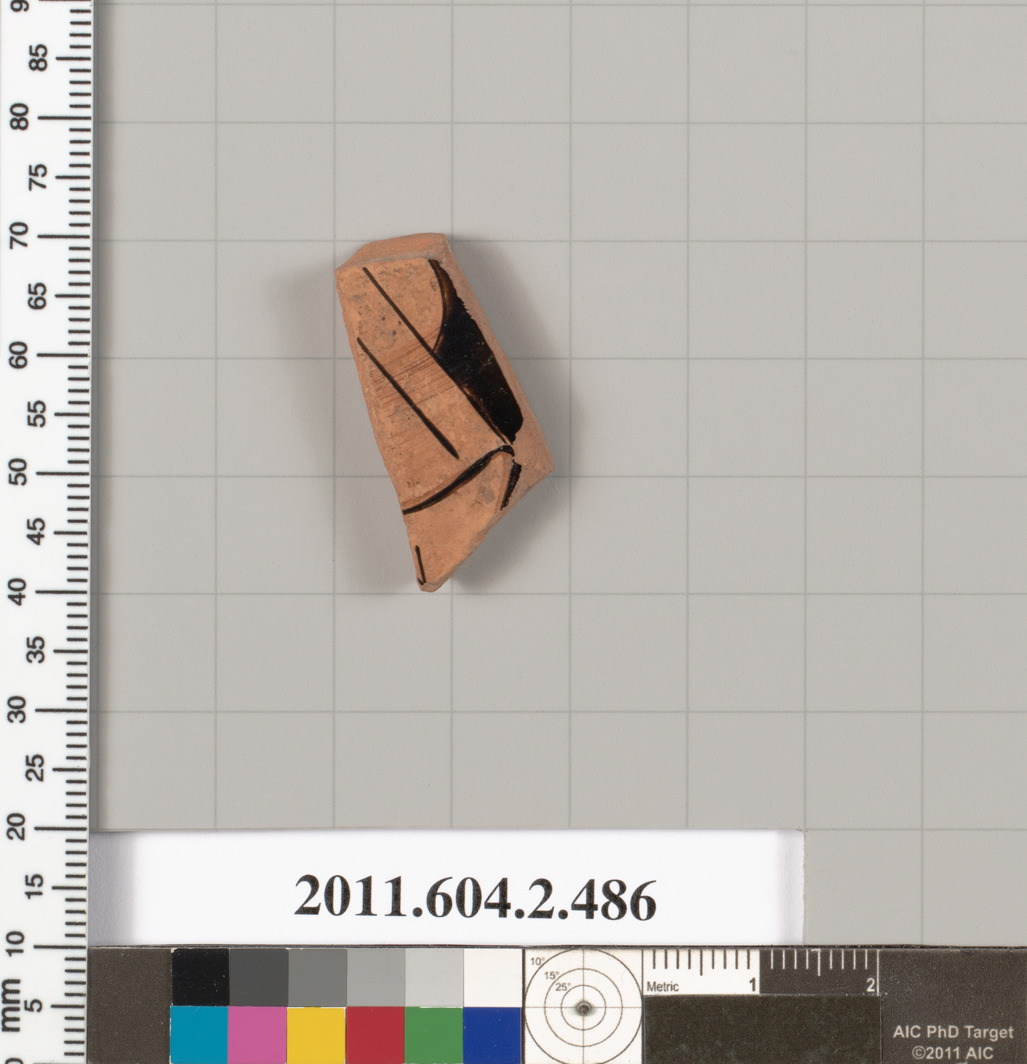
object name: column krater fragment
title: Terracotta fragment of a column-krater (bowl for mixing wine and water)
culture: greek, attic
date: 460-440 BCE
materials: terracotta